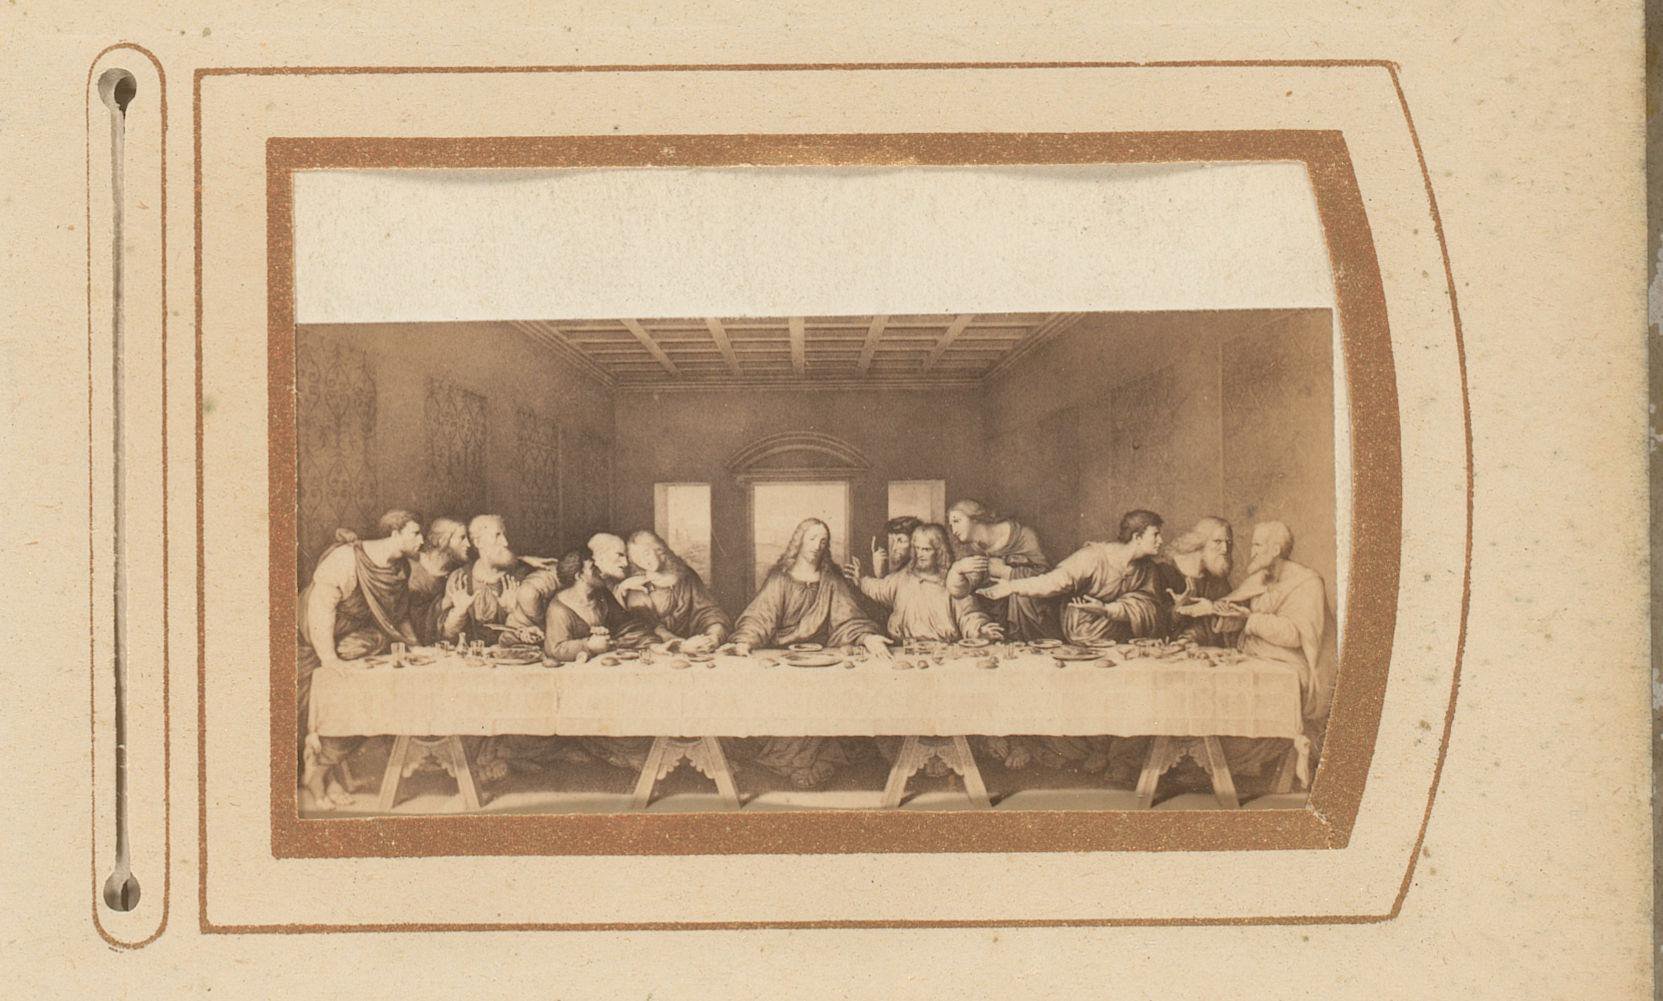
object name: photograph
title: Fotoreproductie van Het laatst avondmaal door Leonardo da Vinci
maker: leonardo da vinci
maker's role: artist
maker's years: 1452-1519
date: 1850-1900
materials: cardboard, photographic support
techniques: albumen print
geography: florence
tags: last supper (in general) (matthew 26:21-35; mark 14:18-31; luke 22:3, 22:15-23; john 13:21-38)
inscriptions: annotation: ‘Leon. da Vinci/ Mailand/ 114’, inscription: ‘FRATELLI ALINARI/ FIRENZE/ Piazza S. Gaetano’